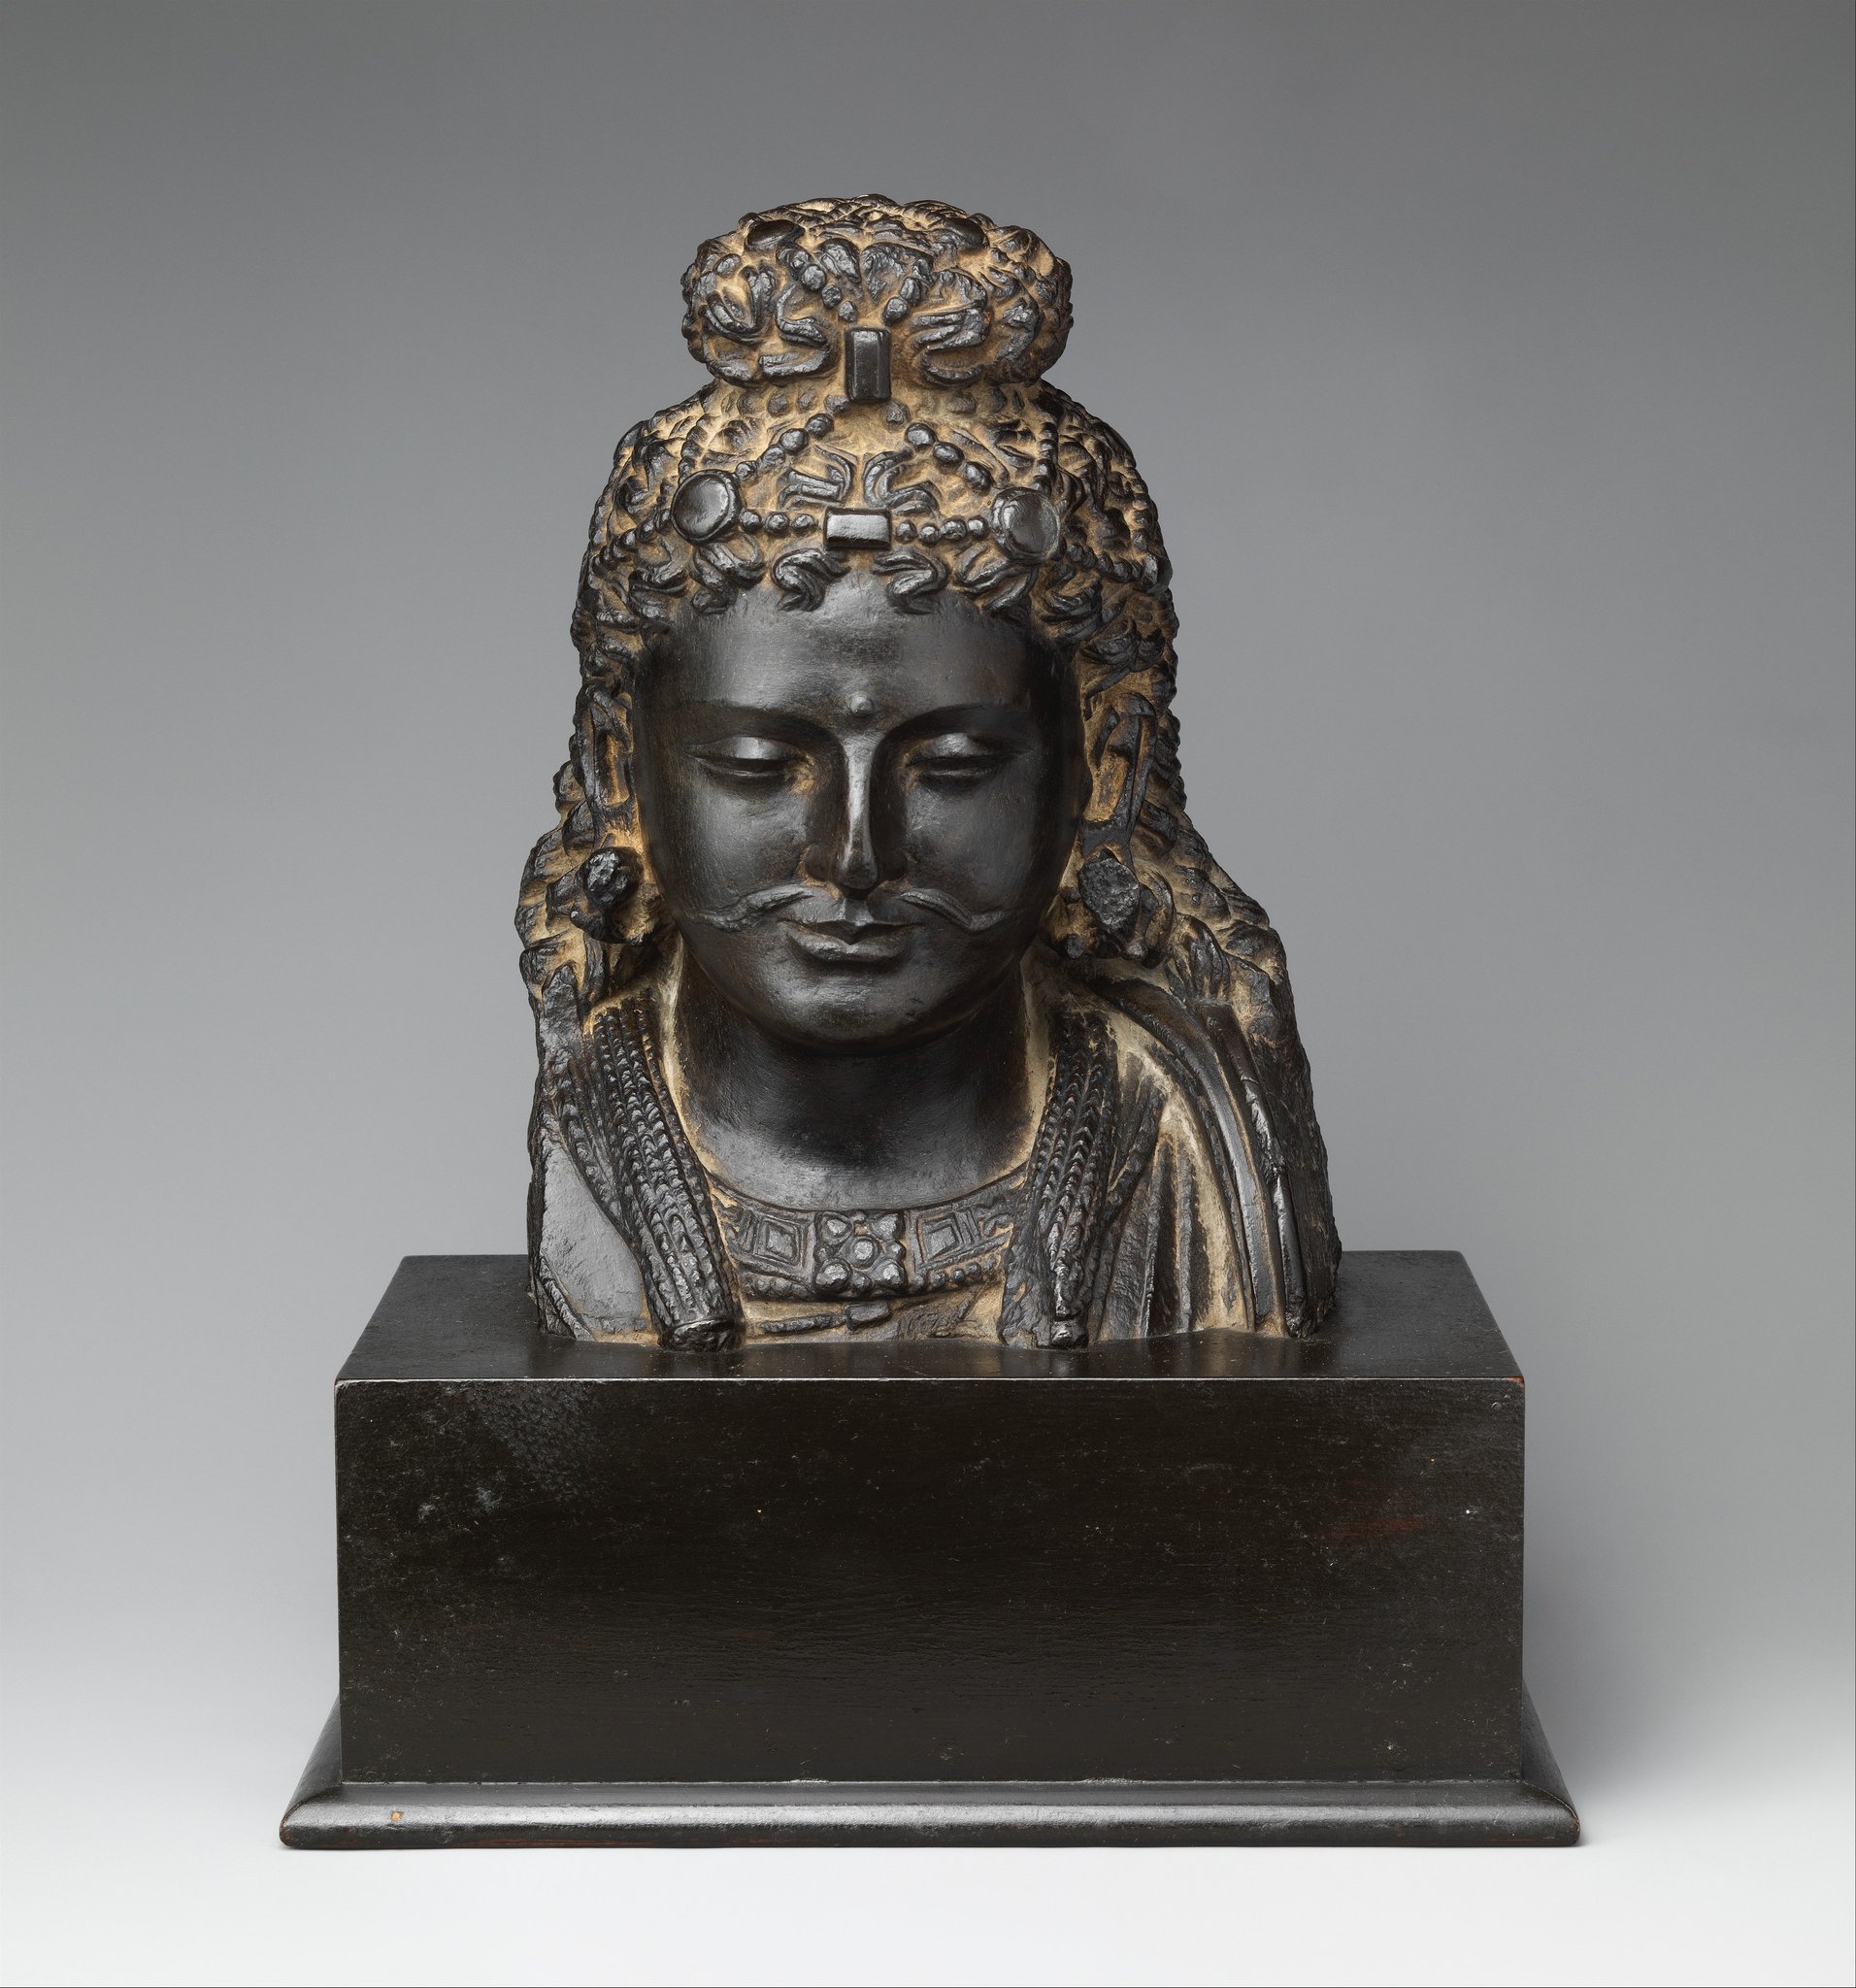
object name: bust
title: Bust of a Bodhisattva, possibly Maitreya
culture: pakistani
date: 101-300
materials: stone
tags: gandhara,bodhisattvas,maitreya